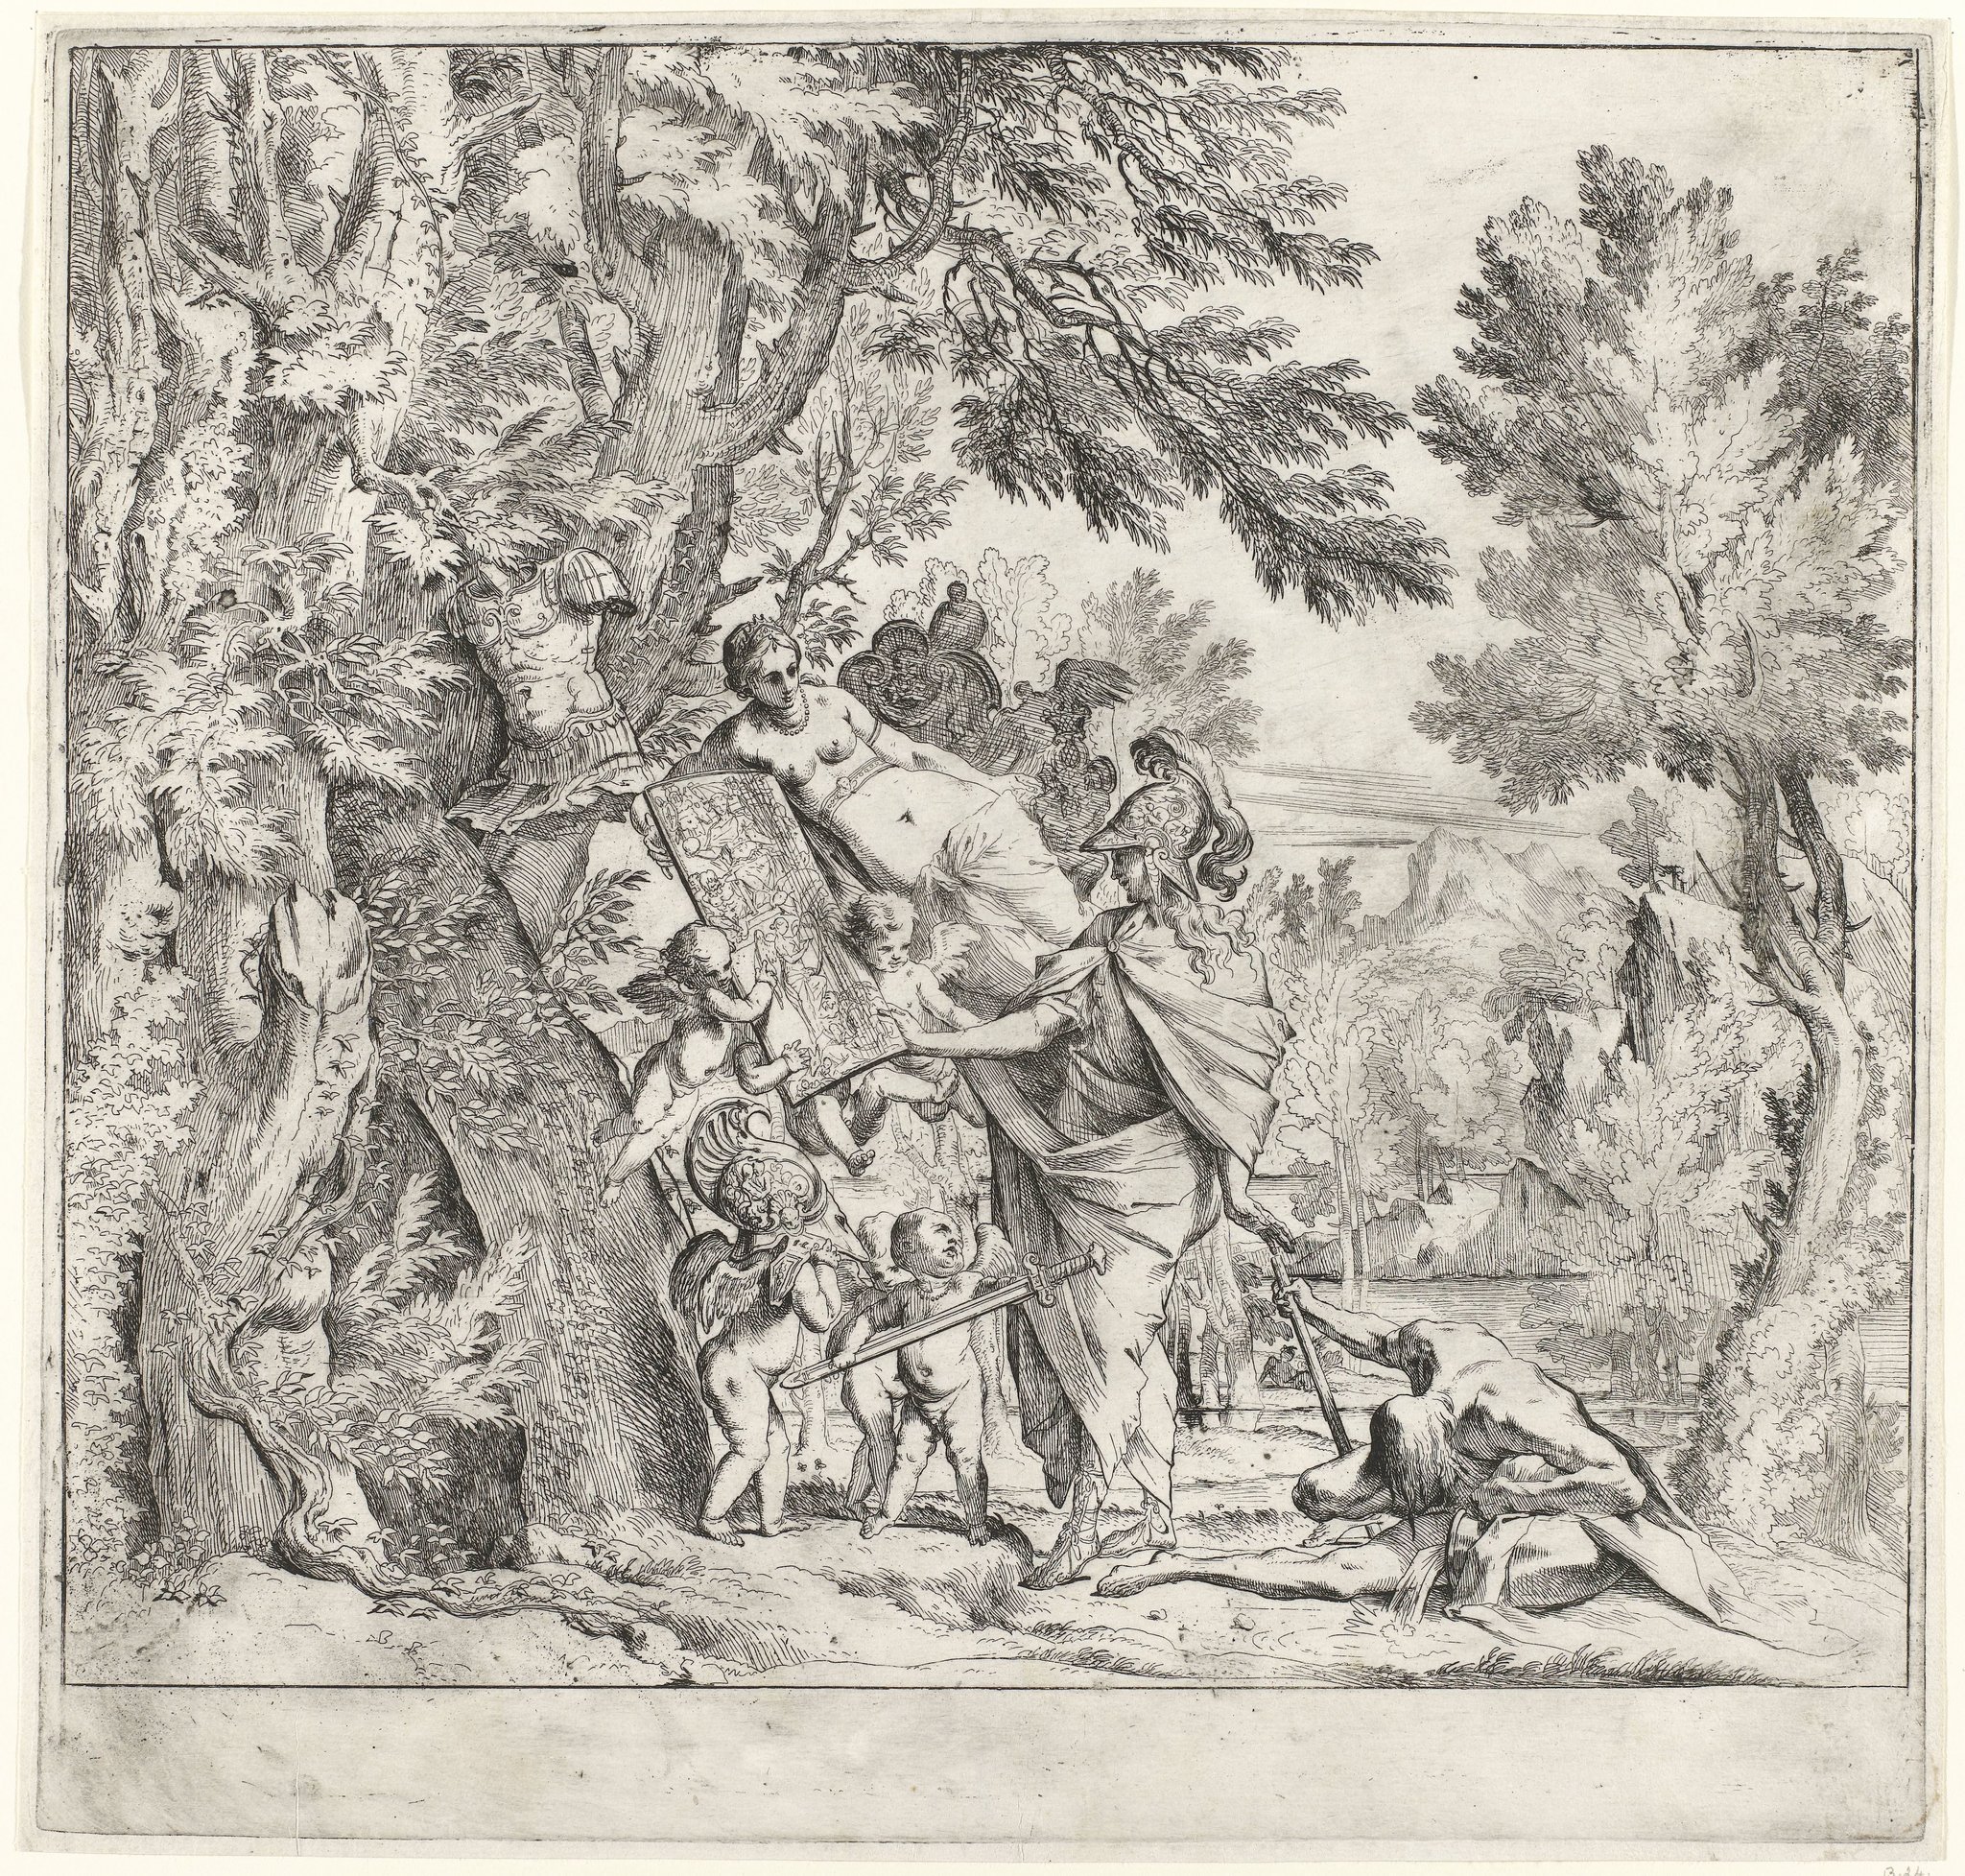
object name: print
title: Venus schenkt Aeneas zijn wapenrusting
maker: pietro testa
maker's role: draughtsman, painter, print maker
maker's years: 1611-1650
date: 1640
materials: paper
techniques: etching, intaglio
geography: italy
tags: venus hands over the armour to aeneas, river personified, 'fiumi' (ripa), cupids: 'amores', 'amoretti', 'putti'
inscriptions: collector's mark: Lugt 240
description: Venus schenkt Aeneas de wapenrusting die Vulcanus voor hem heeft gemaakt. Een harnas hangt links in een boom en een schild, helm en zwaard worden door putti aan Aeneas gepresenteerd. Rechts een riviergod.